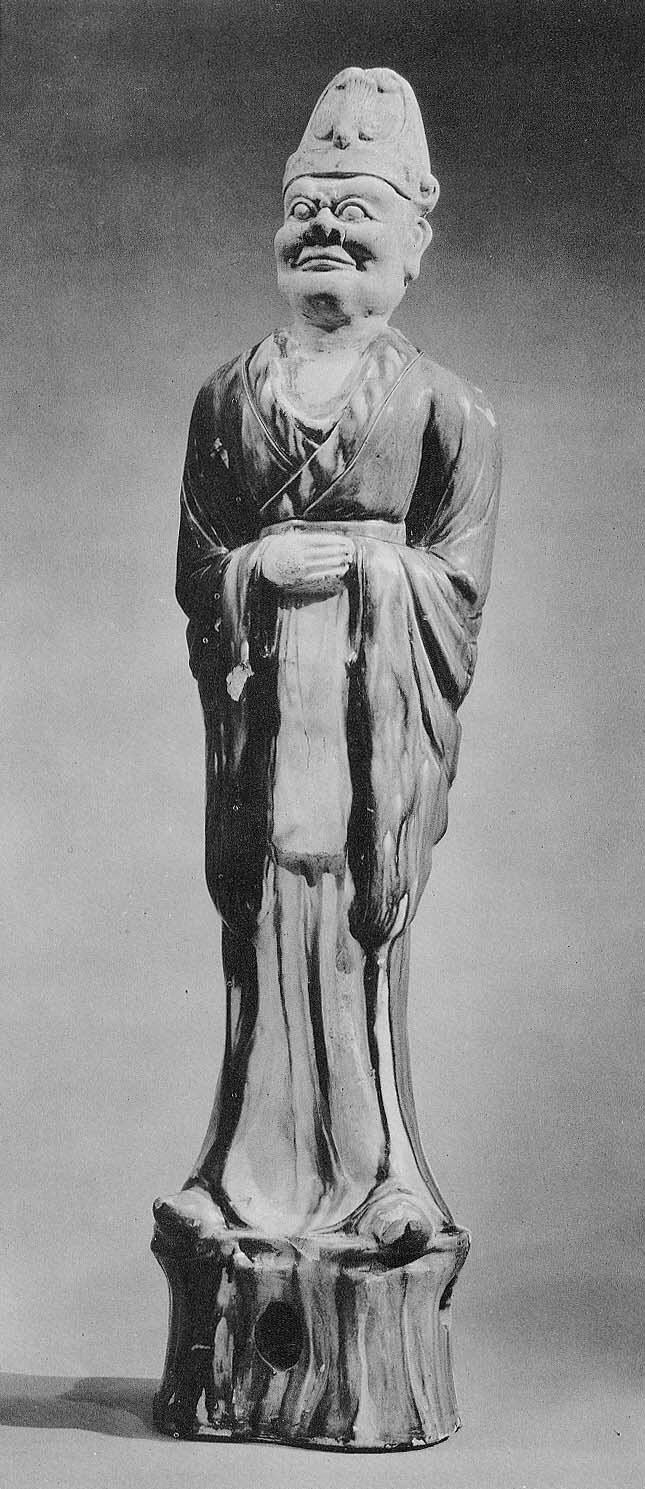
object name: figure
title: Civil official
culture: chinese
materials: earthenware, glaze, pigment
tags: men